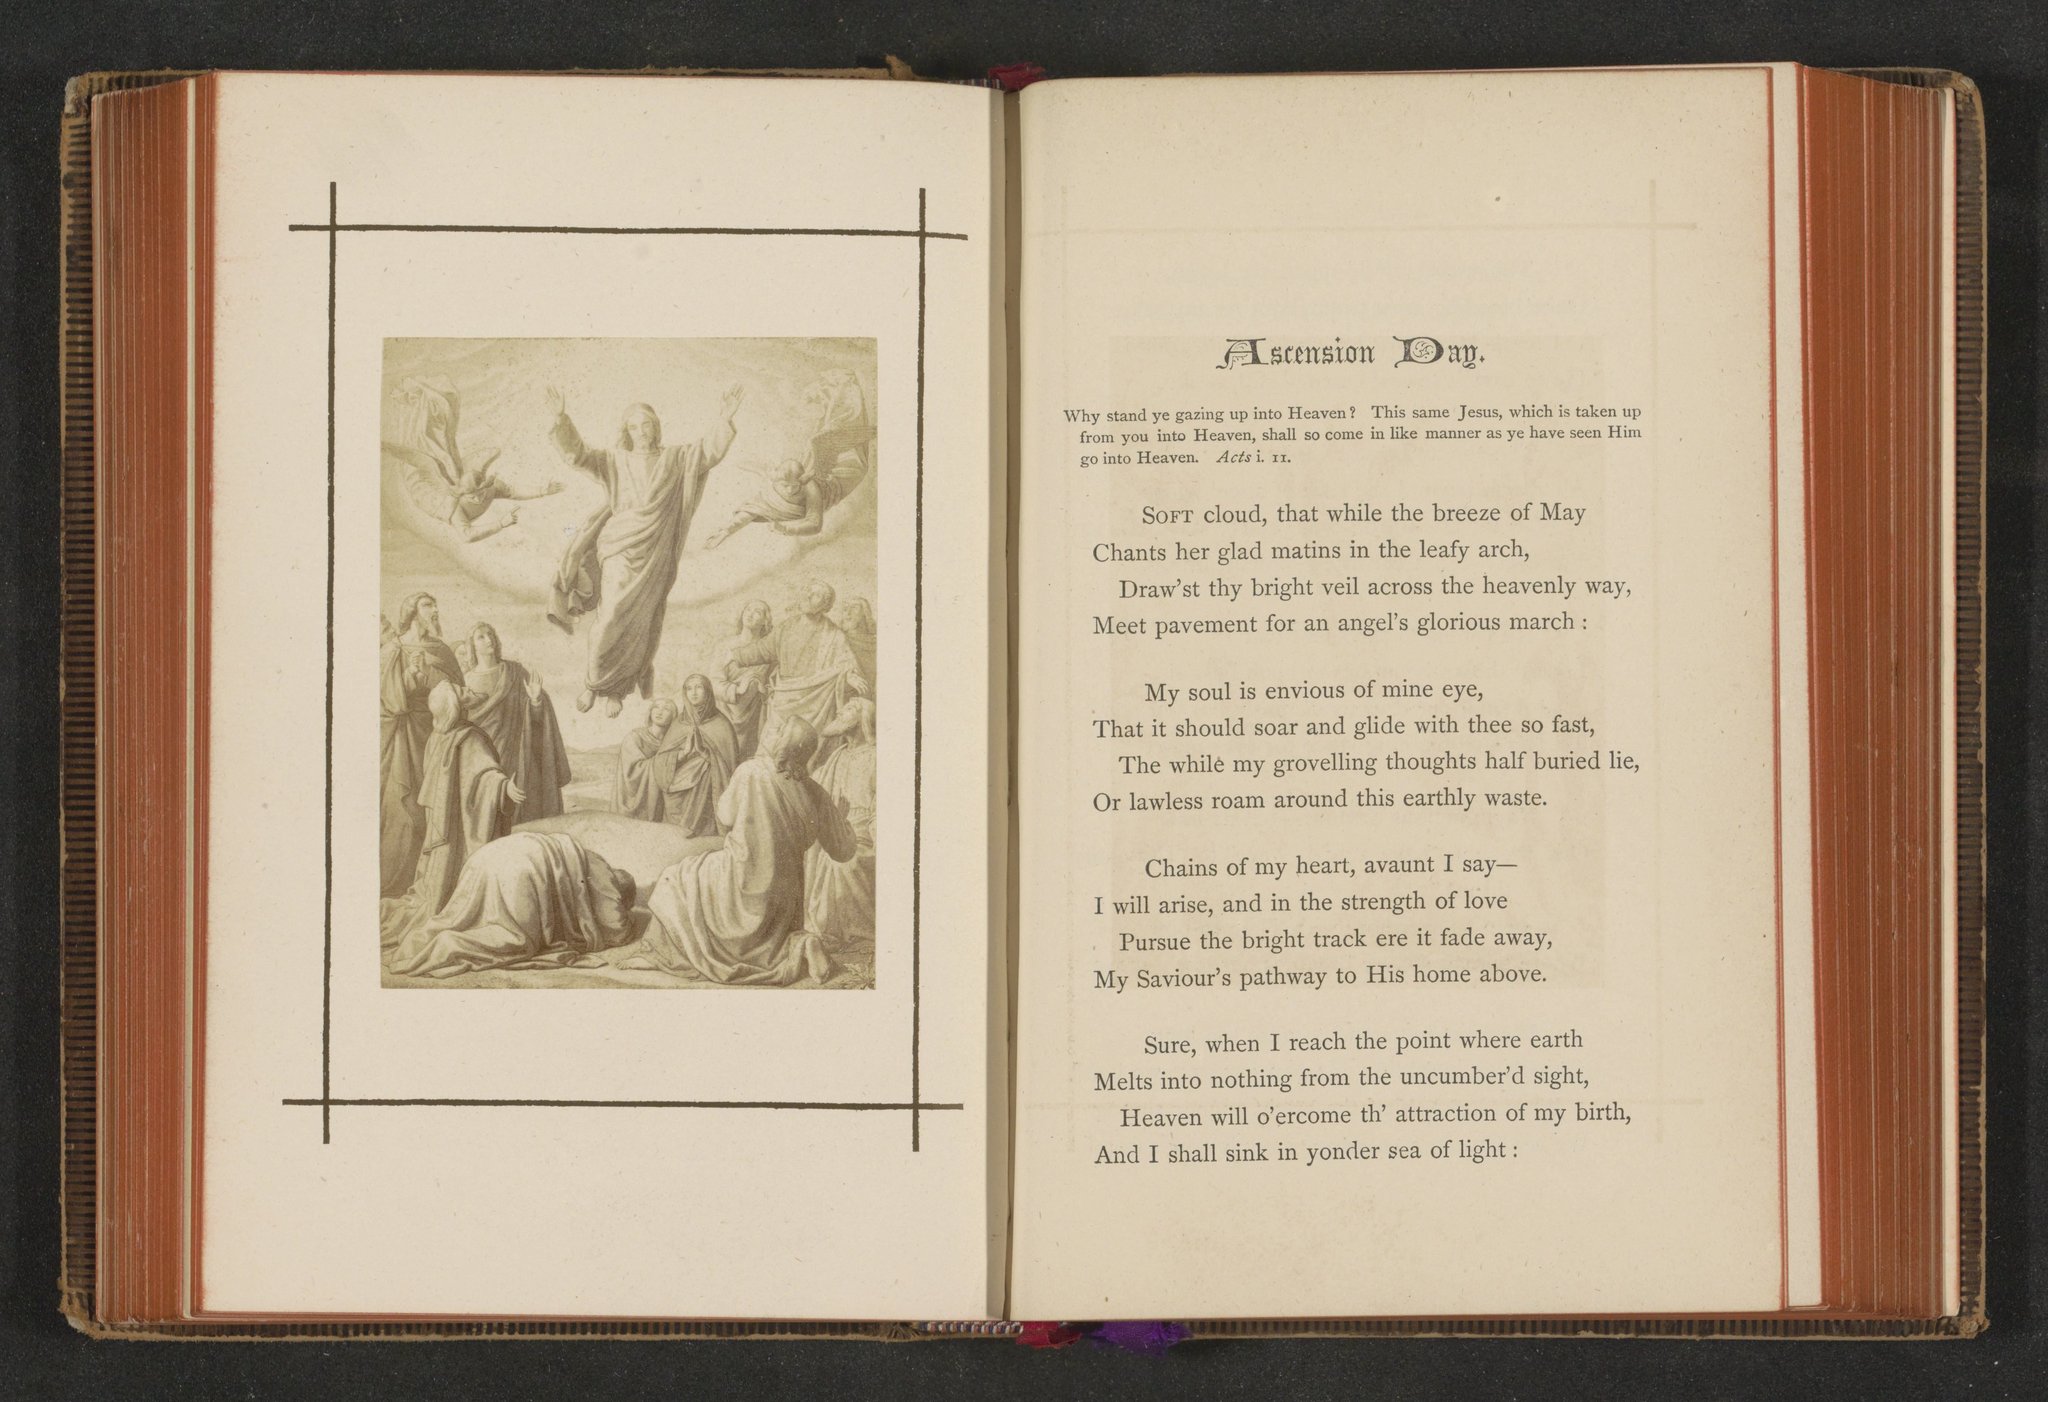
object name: page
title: Fotoreproductie van een prent, voorstellende de hemelvaart van Christus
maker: Anonymous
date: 1865-1870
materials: photographic support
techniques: albumen print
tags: the ascension (christ surrounded by radiant light or in a mandorla)